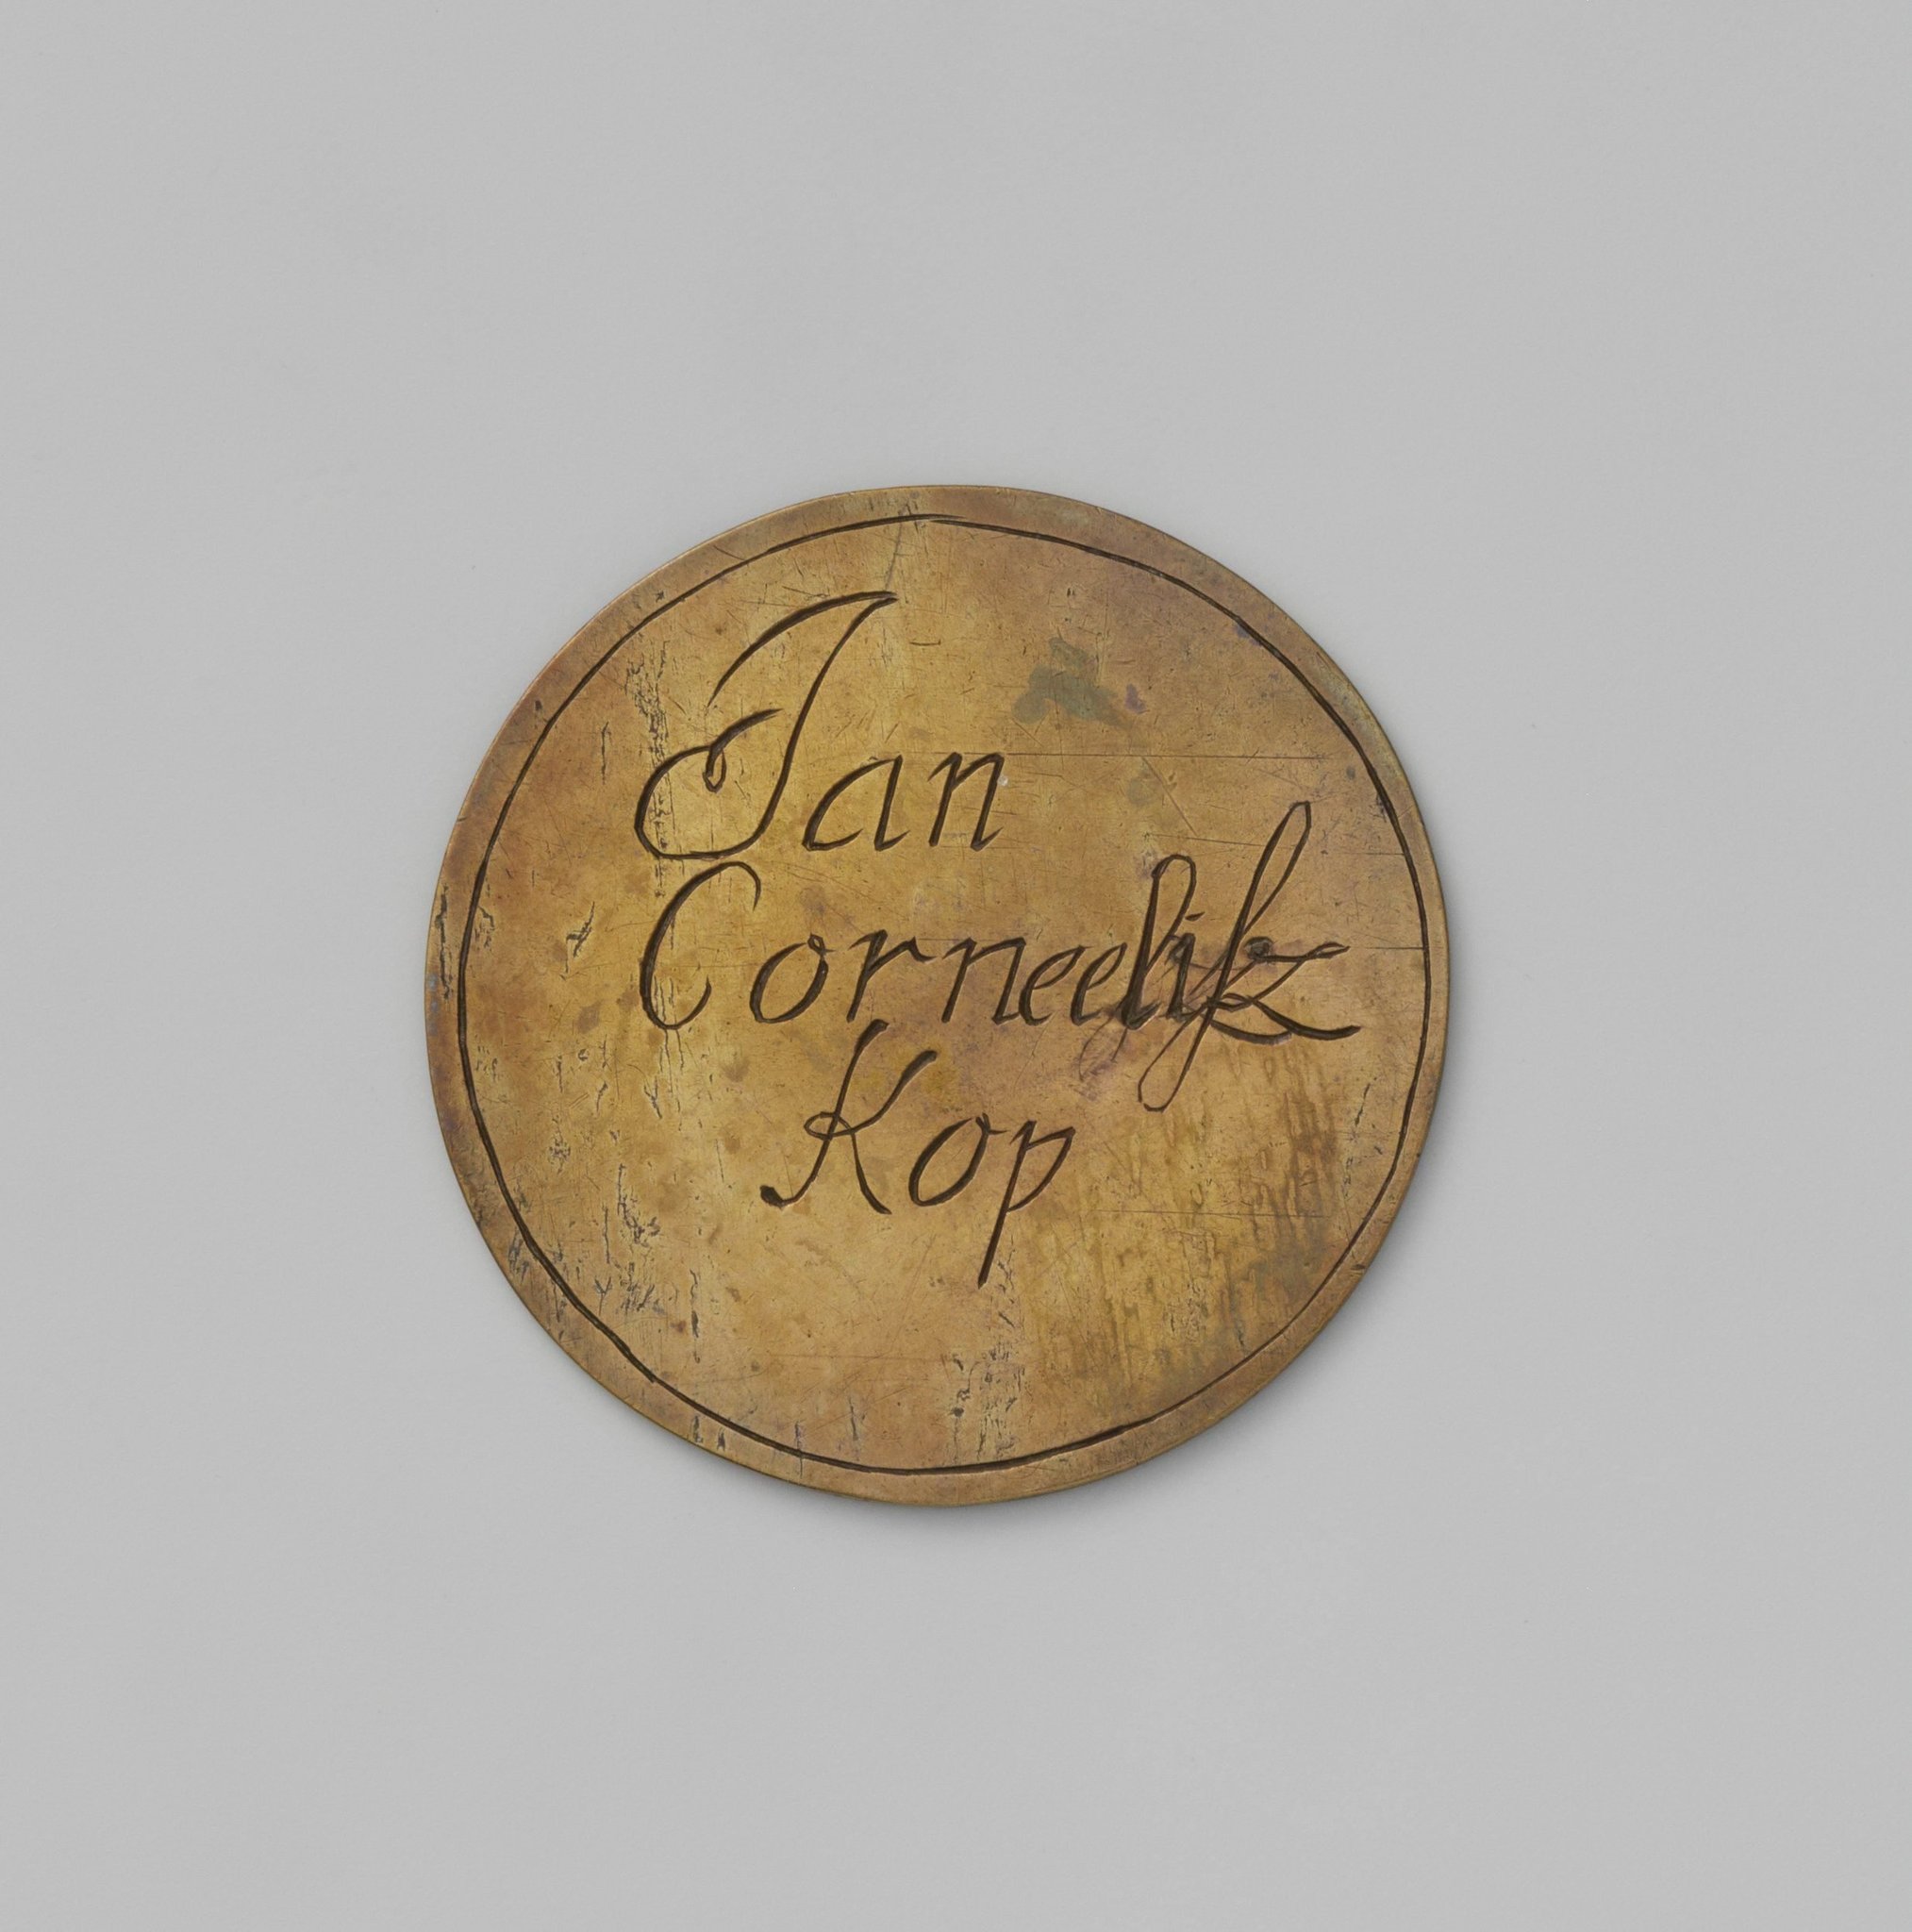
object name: medal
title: Sawyers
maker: Anonymous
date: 1695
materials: brass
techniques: engraving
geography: amsterdam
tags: amsterdam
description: Guild medals Members of trade guilds had to identify themselves with a medal at their meetings.